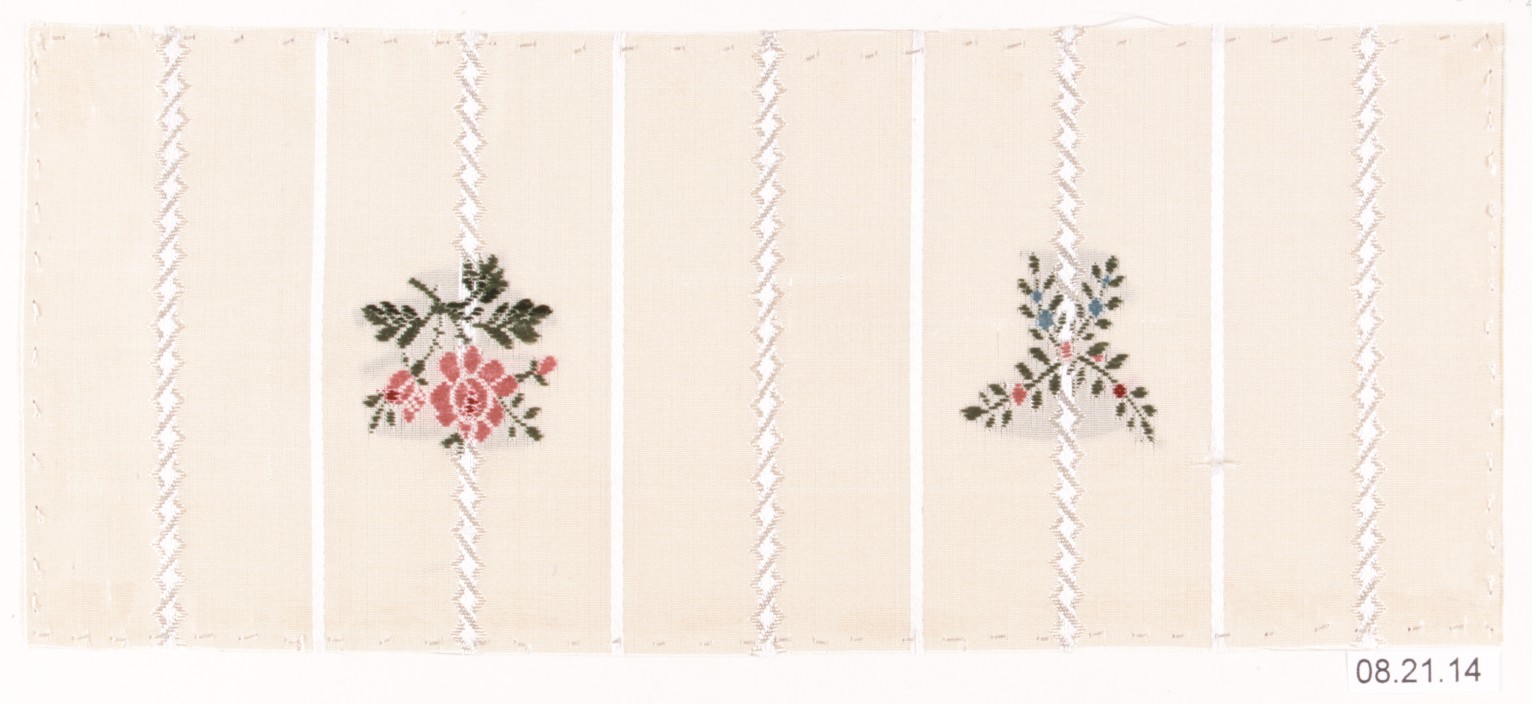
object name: textile sample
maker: Anonymous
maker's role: designer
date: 1900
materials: silk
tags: flowers